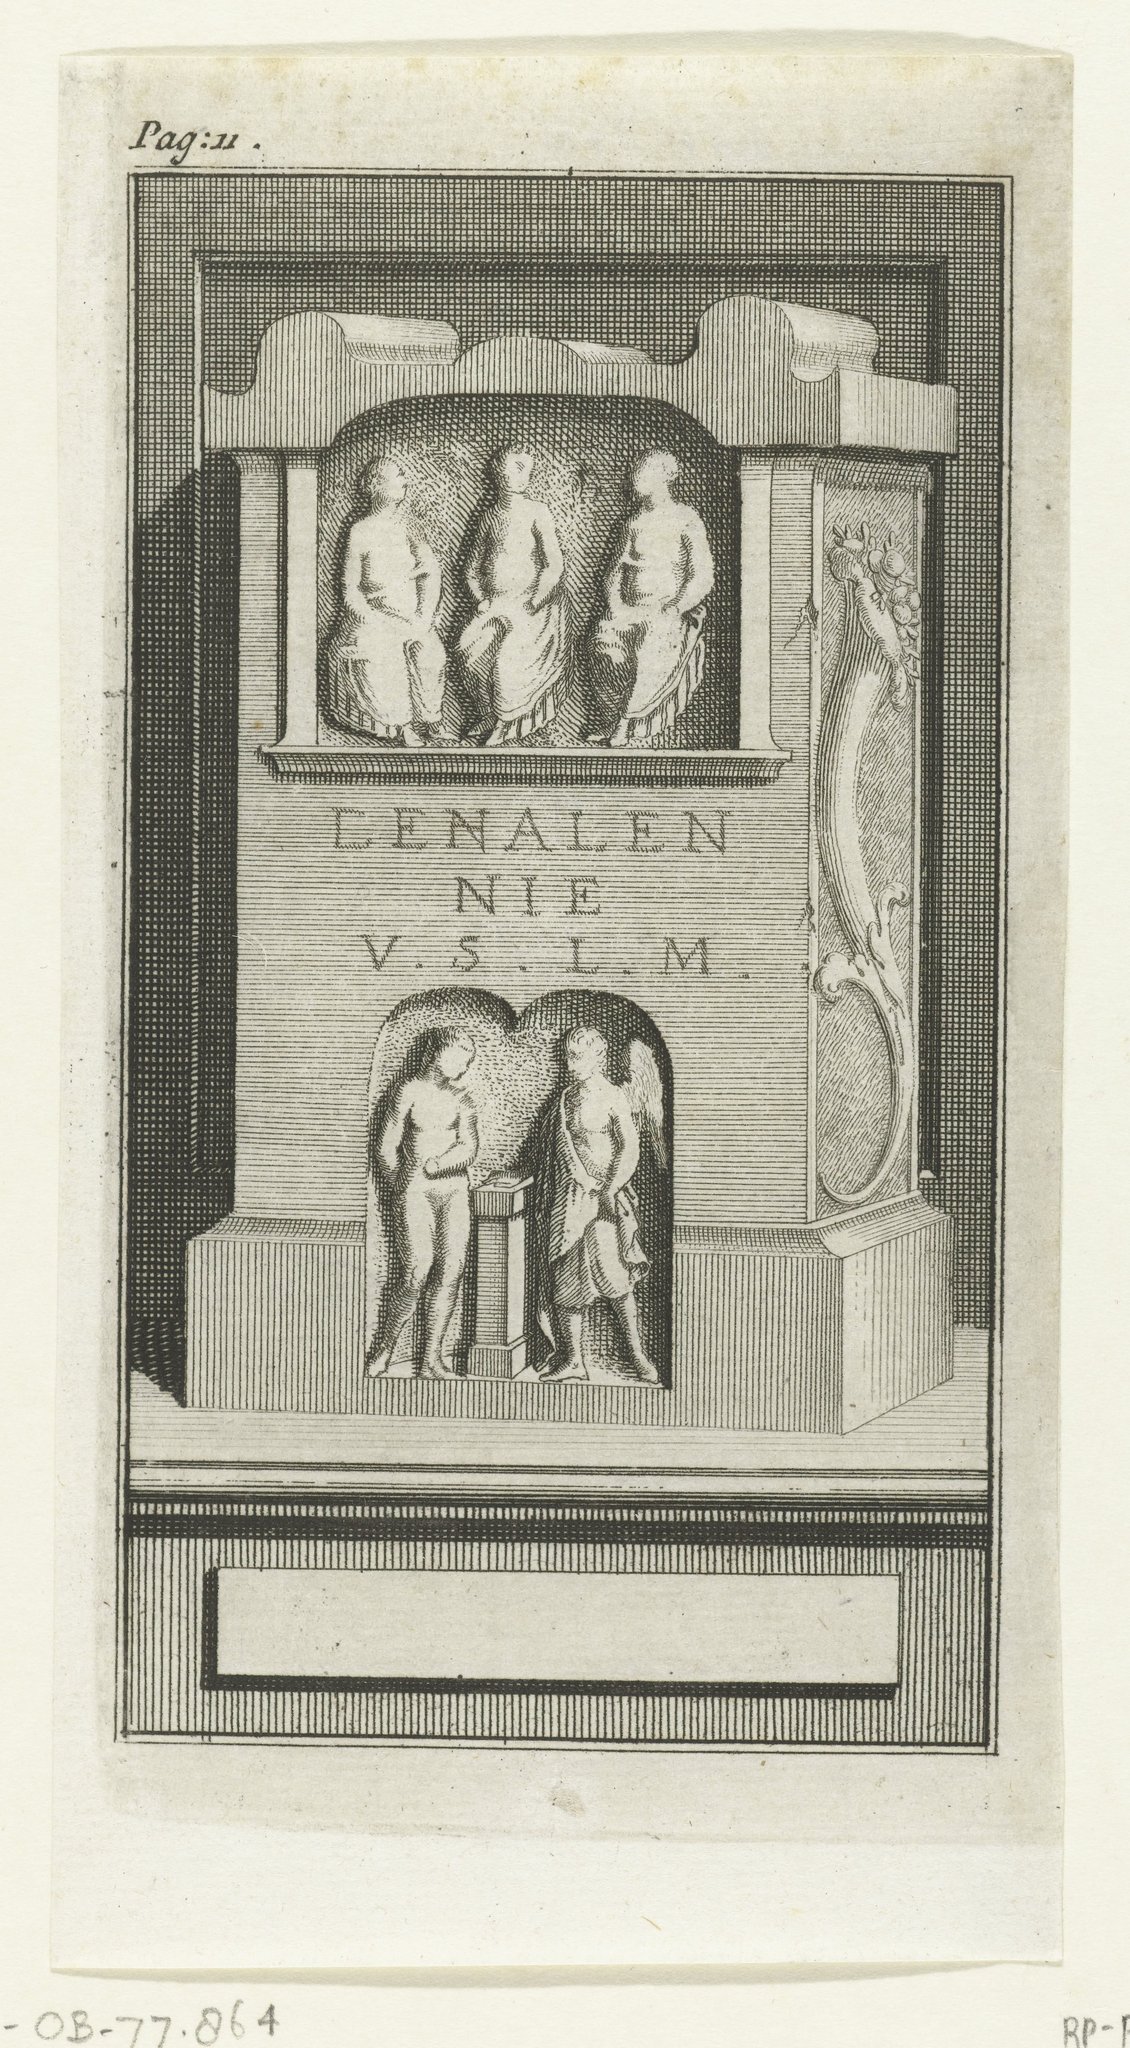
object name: historical object representation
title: Steen van een Nehalennia-altaar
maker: Anonymous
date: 1713-1717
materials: paper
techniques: etching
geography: netherlands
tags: other foreign deities included in the classical pantheon (with name)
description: Illustratie voor: Mattheus Gargon, Walchersche arkadia, Samuel (I) Luchtmans, Leiden 1715-1717, pag. 11.